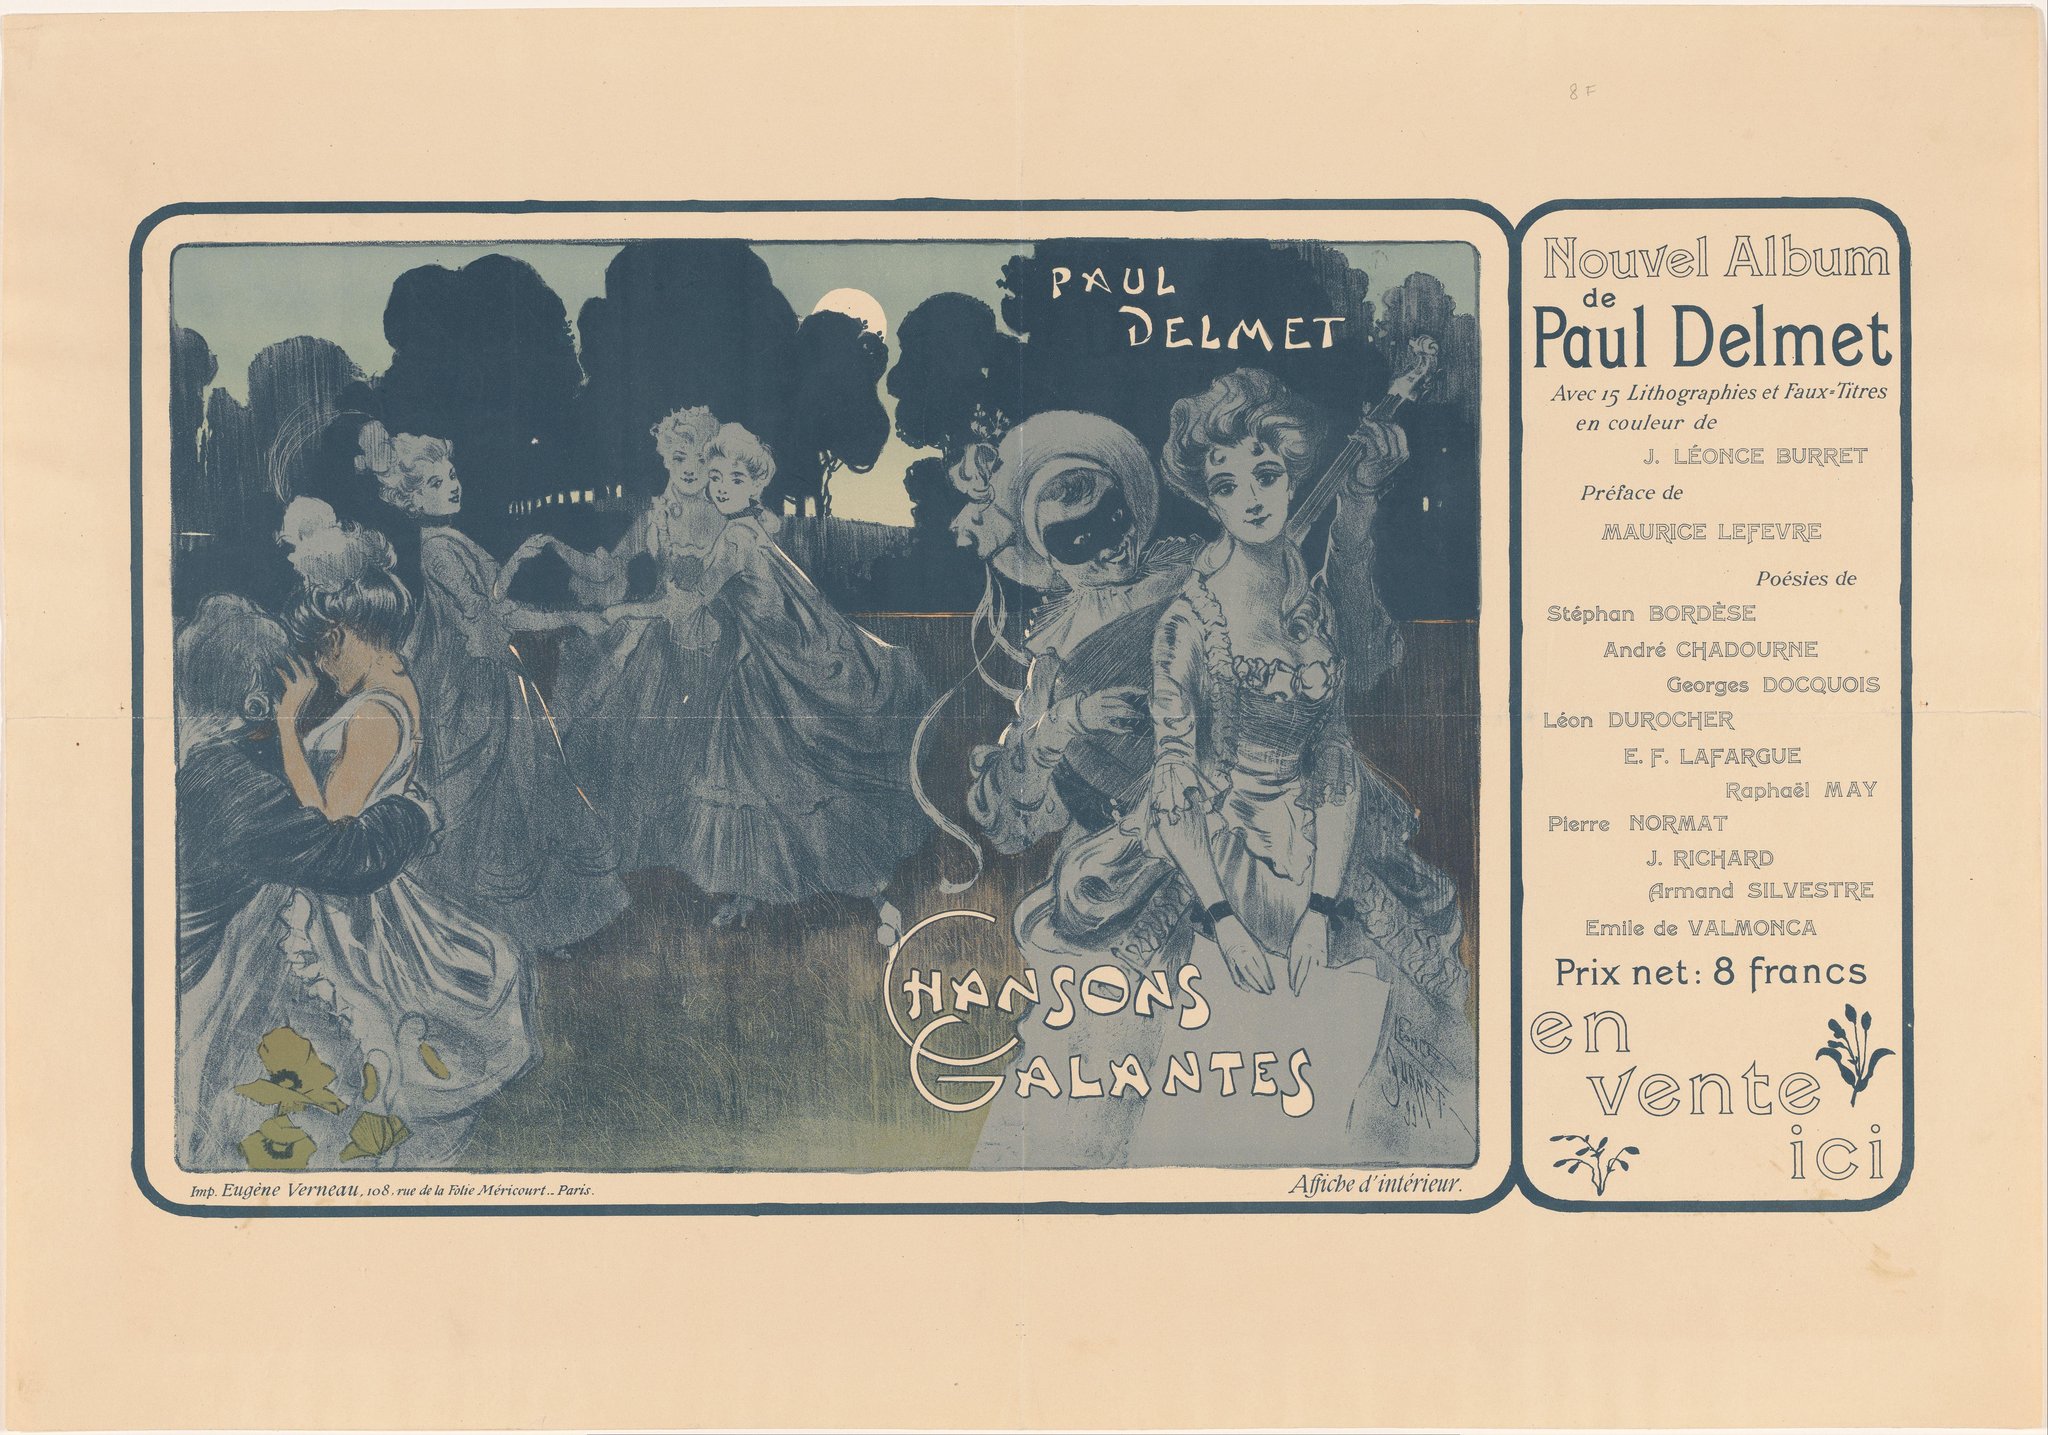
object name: poster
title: Affiche voor Chansons Galantes door Paul Delmet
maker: eugène verneau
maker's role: printer, publisher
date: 1899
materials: paper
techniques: lithograph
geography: paris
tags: cithern, mandolin, guitar, balalaika - cc - out of doors, dancing, moonlight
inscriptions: collector's mark: Lugt 2228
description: Gezelschap in een park bij maanlicht. Rechts een vrouw met bladmuziek in haar handen en een gemaskerde man met een gitaar. Links een man en een vrouw in omhelzing. In de achtergrond drie dansende vrouwen.